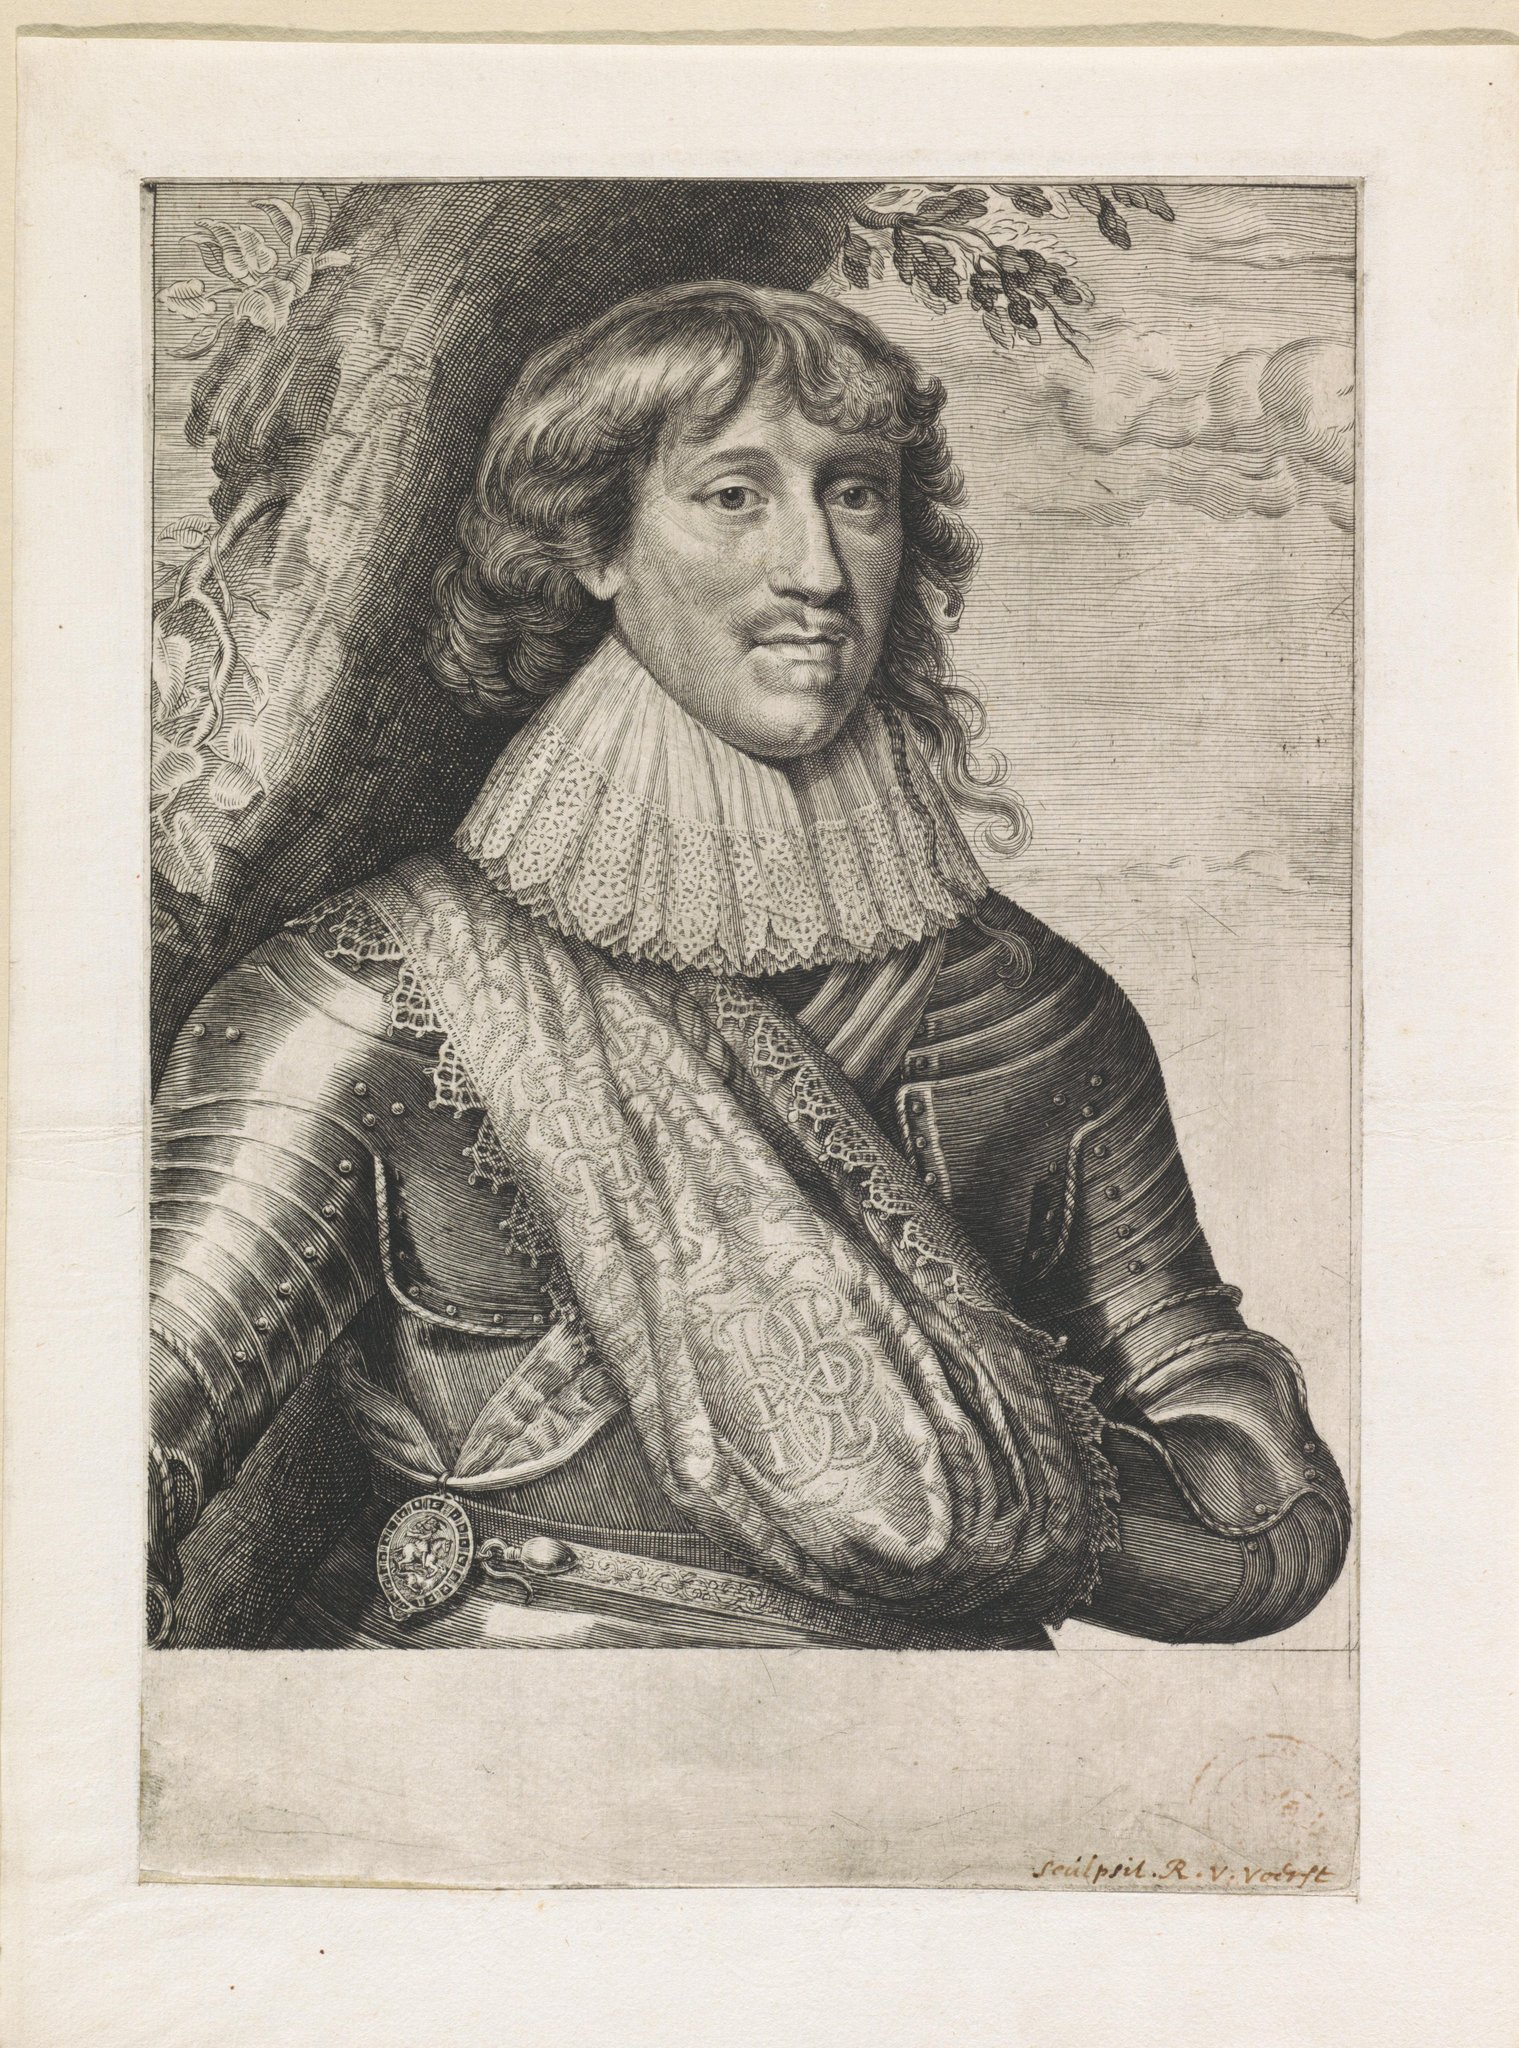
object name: print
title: Portret van Christiaan, hertog van Brunswijk-Wolfenbüttel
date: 1625-1636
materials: paper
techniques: engraving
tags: armour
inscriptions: collector's mark: Lugt 240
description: Portret van Christiaan, hertog van Brunswijk en Lüneburg, militair leider in de strijd tegen de Habsburgers en de Katholieke Liga tijdens de Dertigjarige Oorlog.